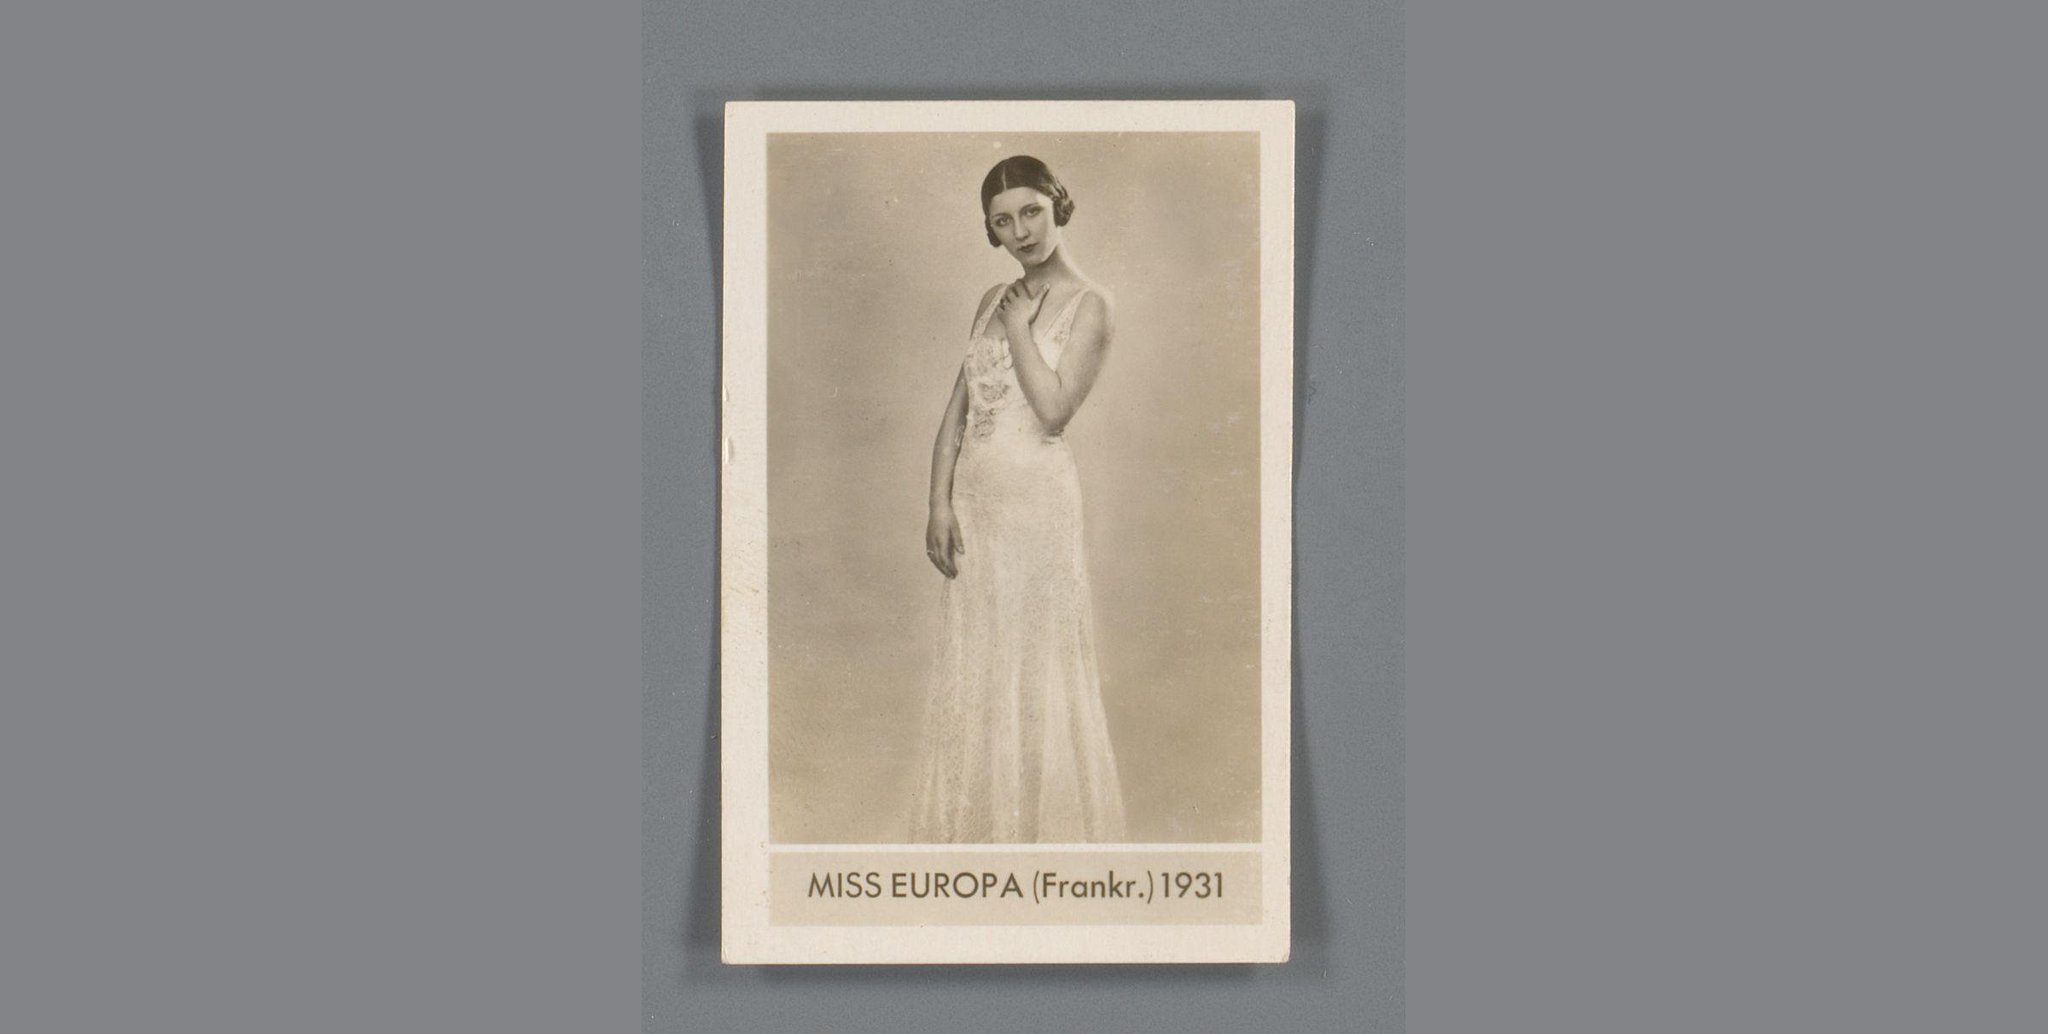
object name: photograph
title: Portret van Jeanne Juilla, Miss Europa 1931, reclame voor Club & Liga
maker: Anonymous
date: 1931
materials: paper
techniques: gelatin silver print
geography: dresden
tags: historical persons - bb - woman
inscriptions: inscription: ‘Die schönsten/ Frauen der Welt/ dargestellt durch die Schön-/ heitsköniginnen aller Länder,/ finden Sie in 190 echten/ Bromsilber-Fotos, die nur den/ CLUB-und-LIGA-Packun-/ gen beiliegen. Eind prächtiges/ Sammel-Album erhalten Sie/ für 75 Pfennig vom Händler/ oder bei Einsendung von/ 75 Pfennig in Briefmarken/ von der Bilderstelle Lohse,/ Dresden A24, Nossener Str. 1./ Ges. gesch. Nachdruck verboten!’